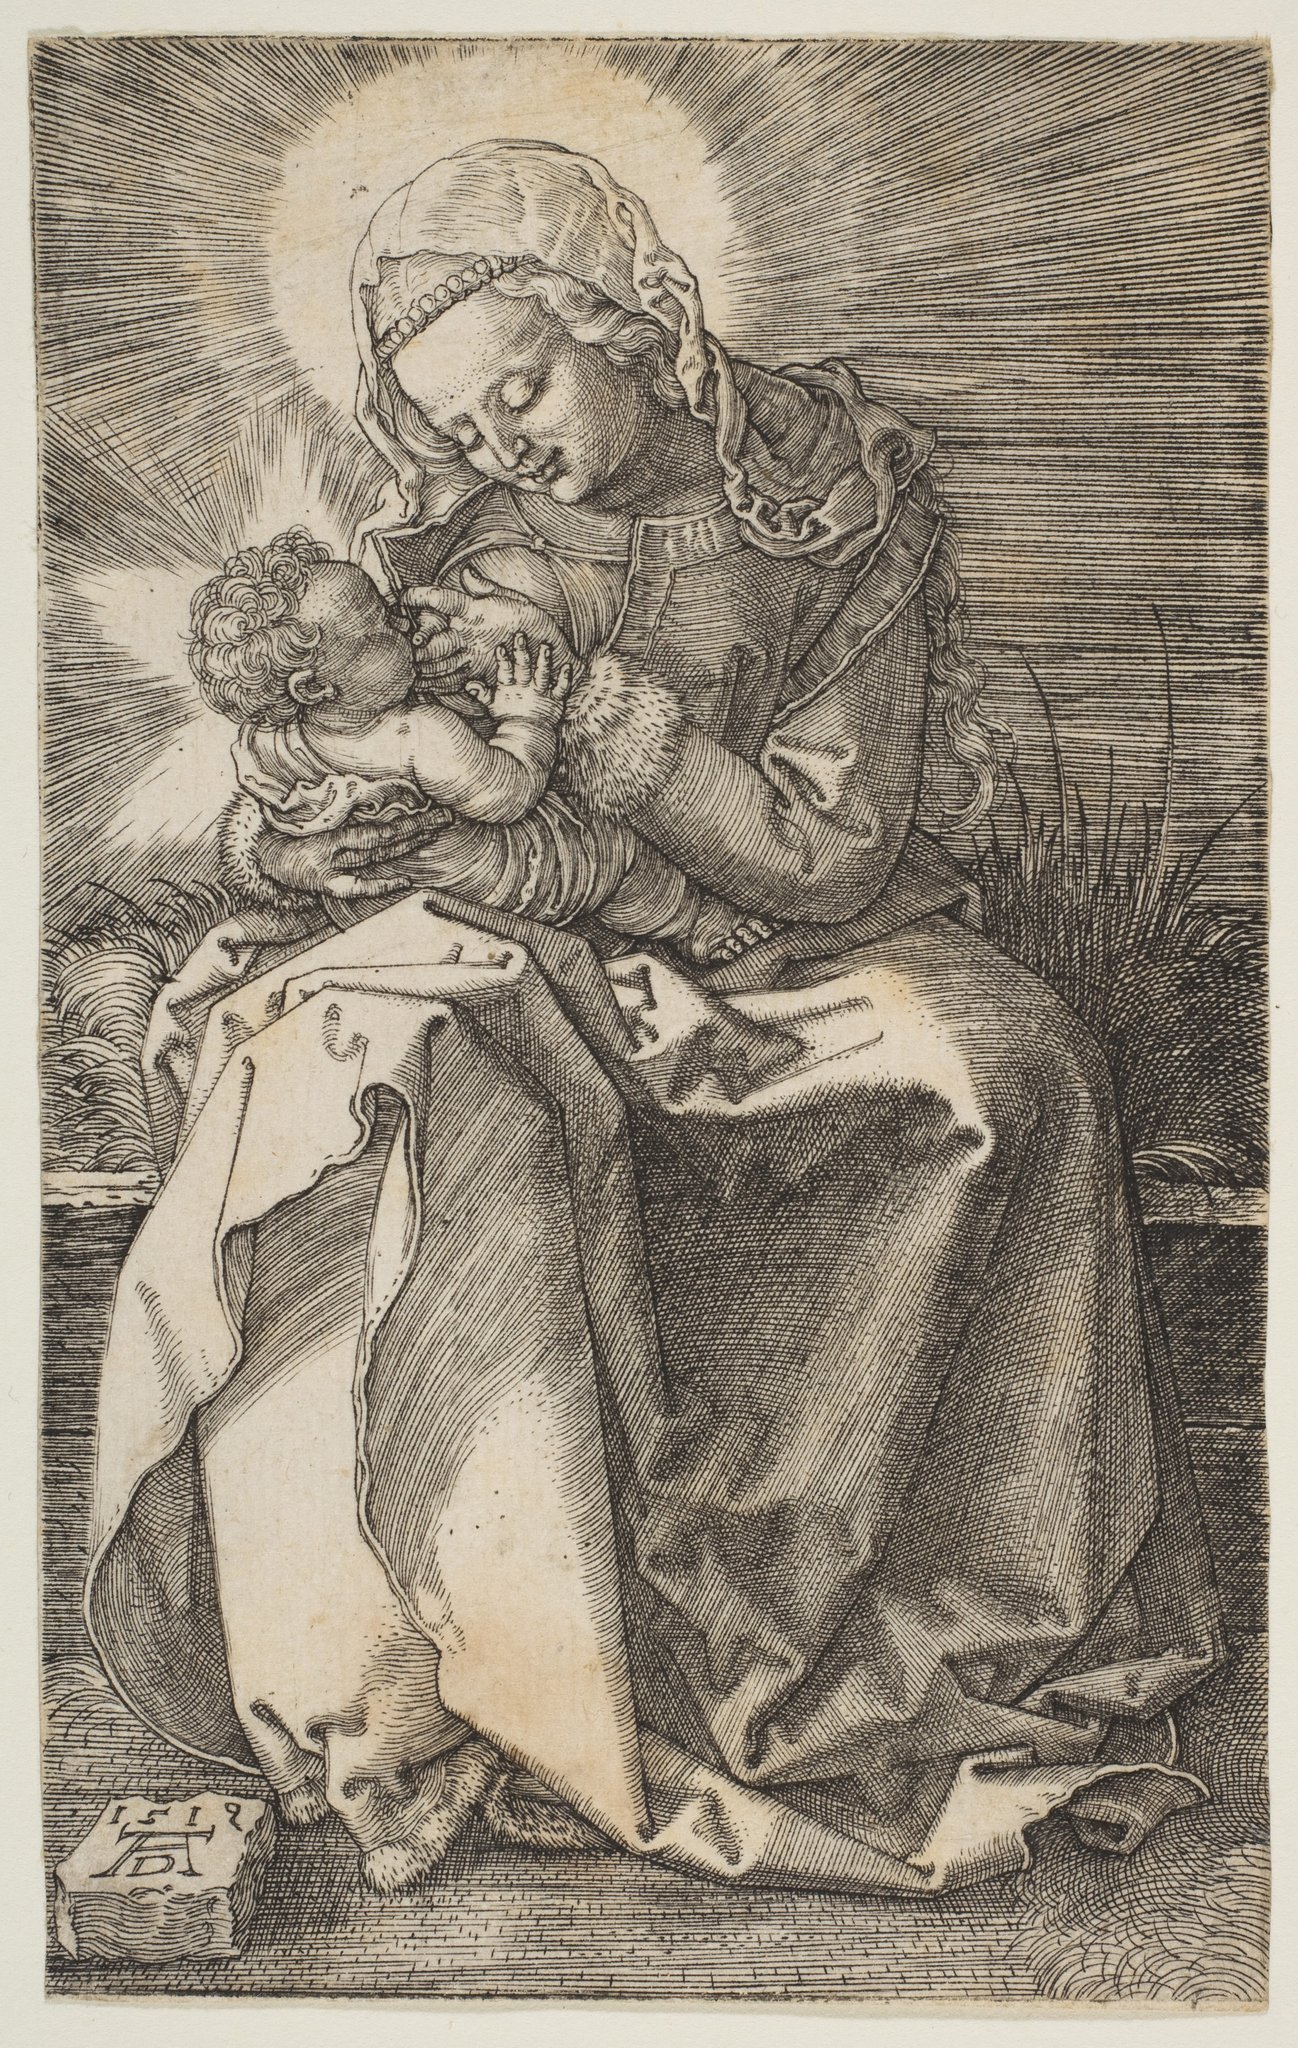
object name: print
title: The Virgin Nursing the Child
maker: albrecht dürer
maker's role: artist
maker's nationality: german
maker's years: 1471-1528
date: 1519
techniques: engraving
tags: madonna and child